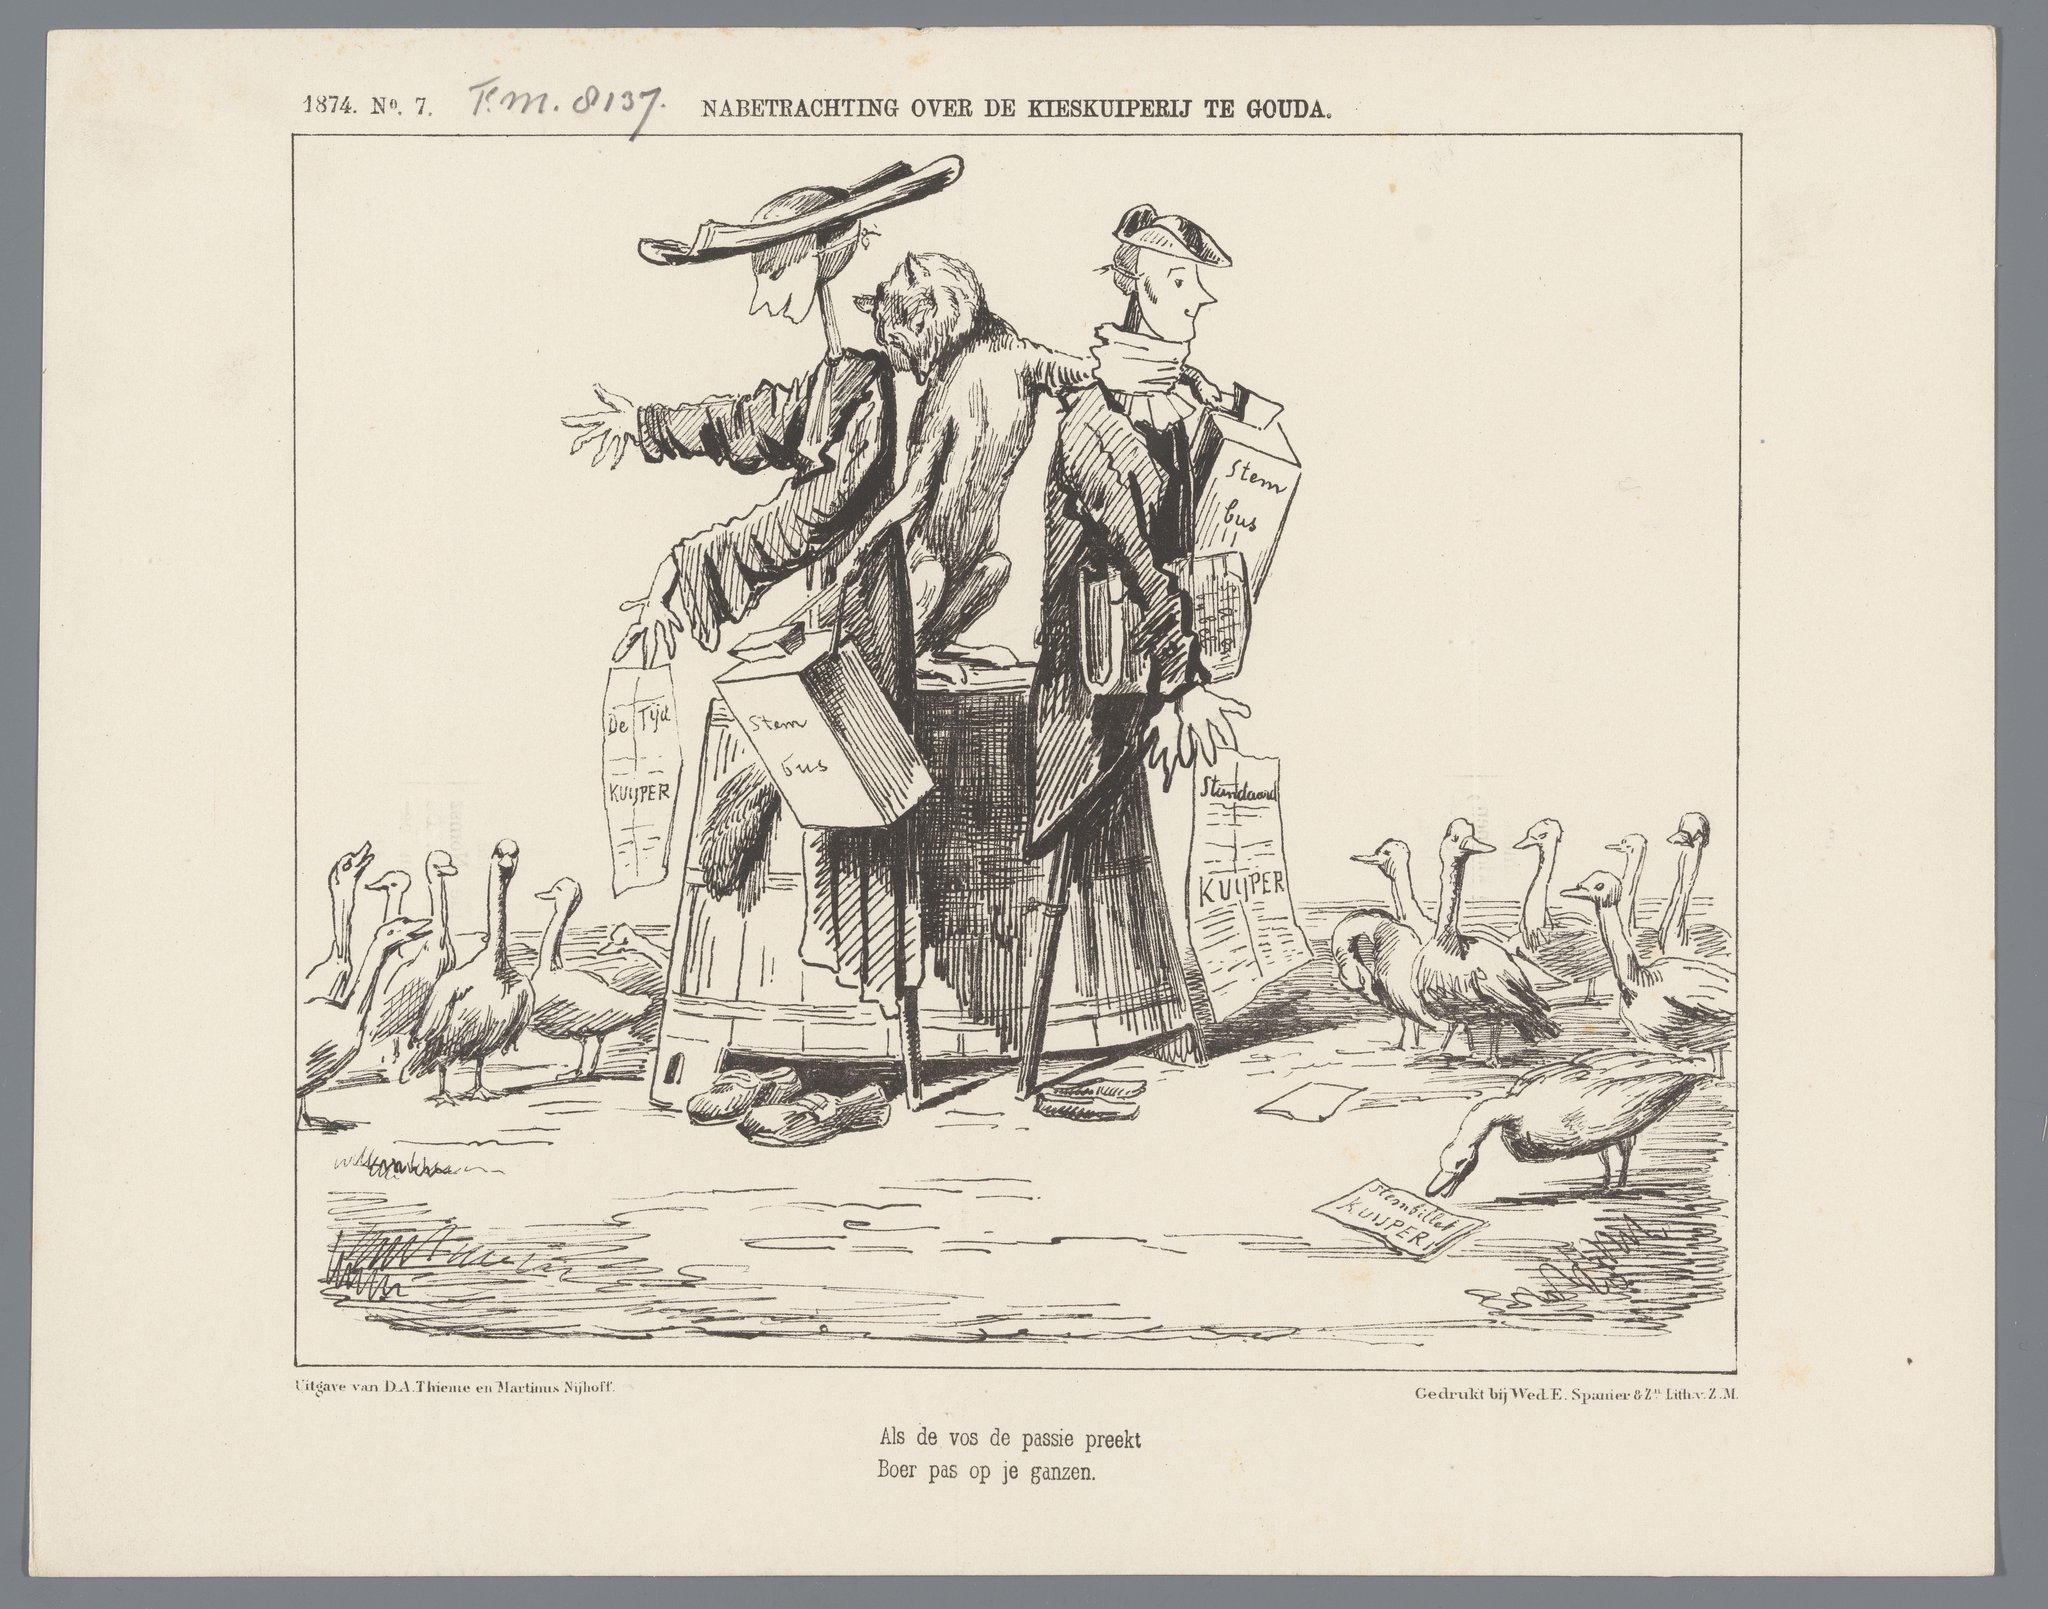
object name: cartoon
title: Spotprent op de verkiezing van Abraham Kuyper in Gouda, 1874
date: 1874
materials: paper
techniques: lithograph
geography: arnhem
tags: the hague, abraham kuyper, wooden container: barrel, cask, bucket, gouda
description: Spotprent op de verkiezing van Abraham Kuyper in Gouda. Plaat verschenen bij het weekblad De Nederlandsche Spectator, nr. 7, 1874.